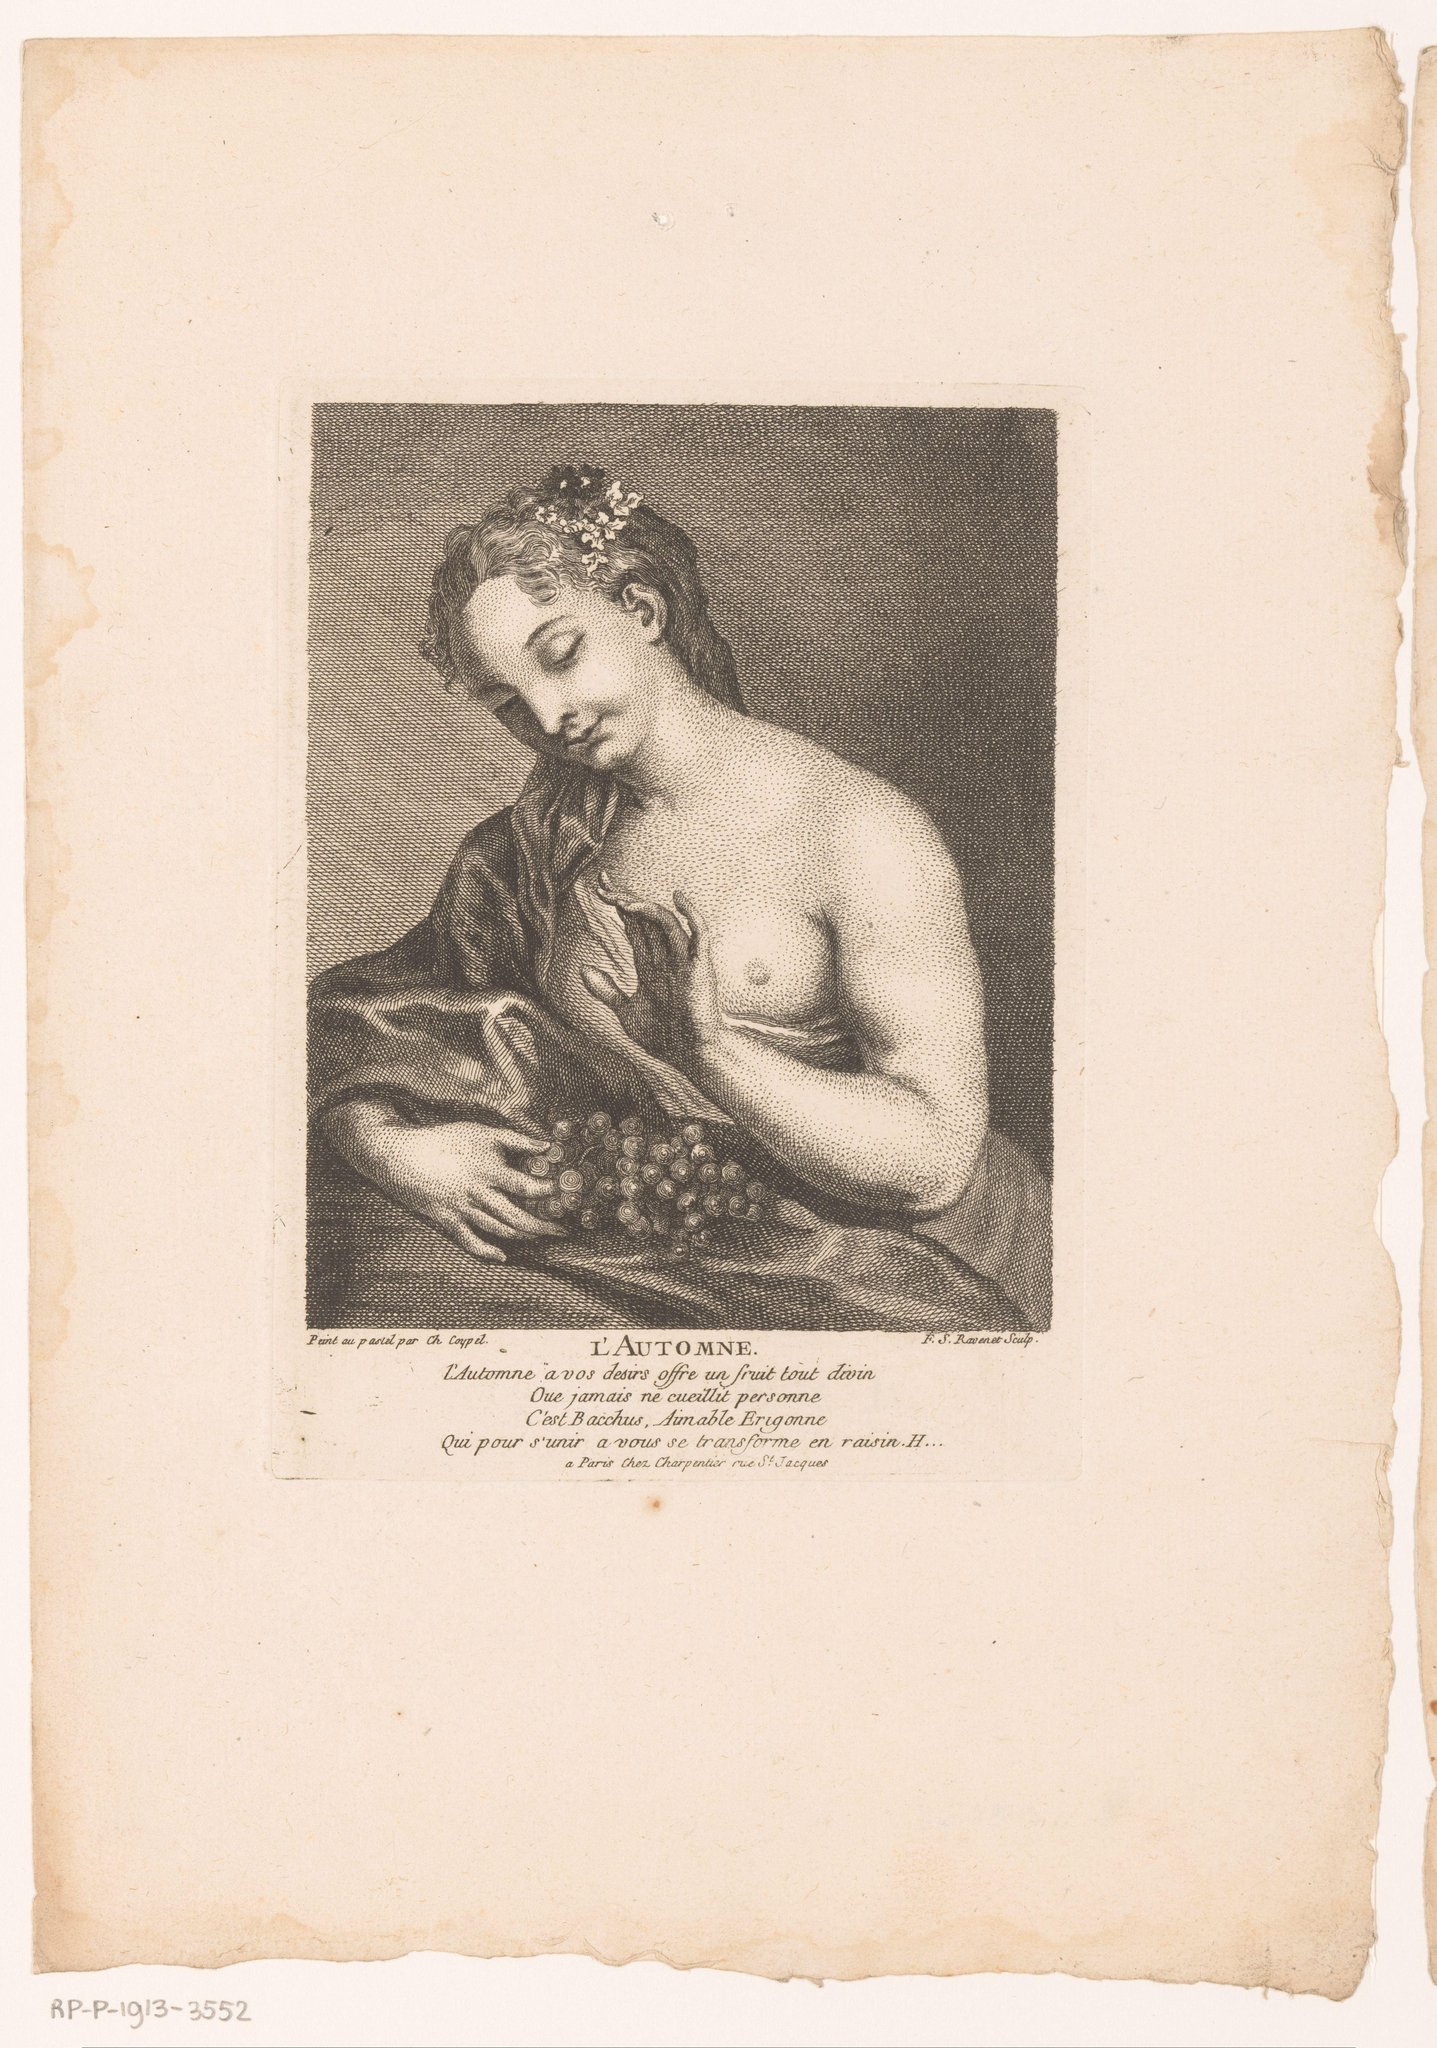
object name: print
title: L'Automne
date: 1716-1774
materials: paper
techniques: engraving, etching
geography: paris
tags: seasons of the year represented by scenes showing human activities, usually in a landscape, autumn, fall, 'autumnus'; 'autunno' (ripa)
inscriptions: collector's mark: Lugt 2228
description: Personificatie van de herfst als een vrouw met een tros druiven, naar links gewend.